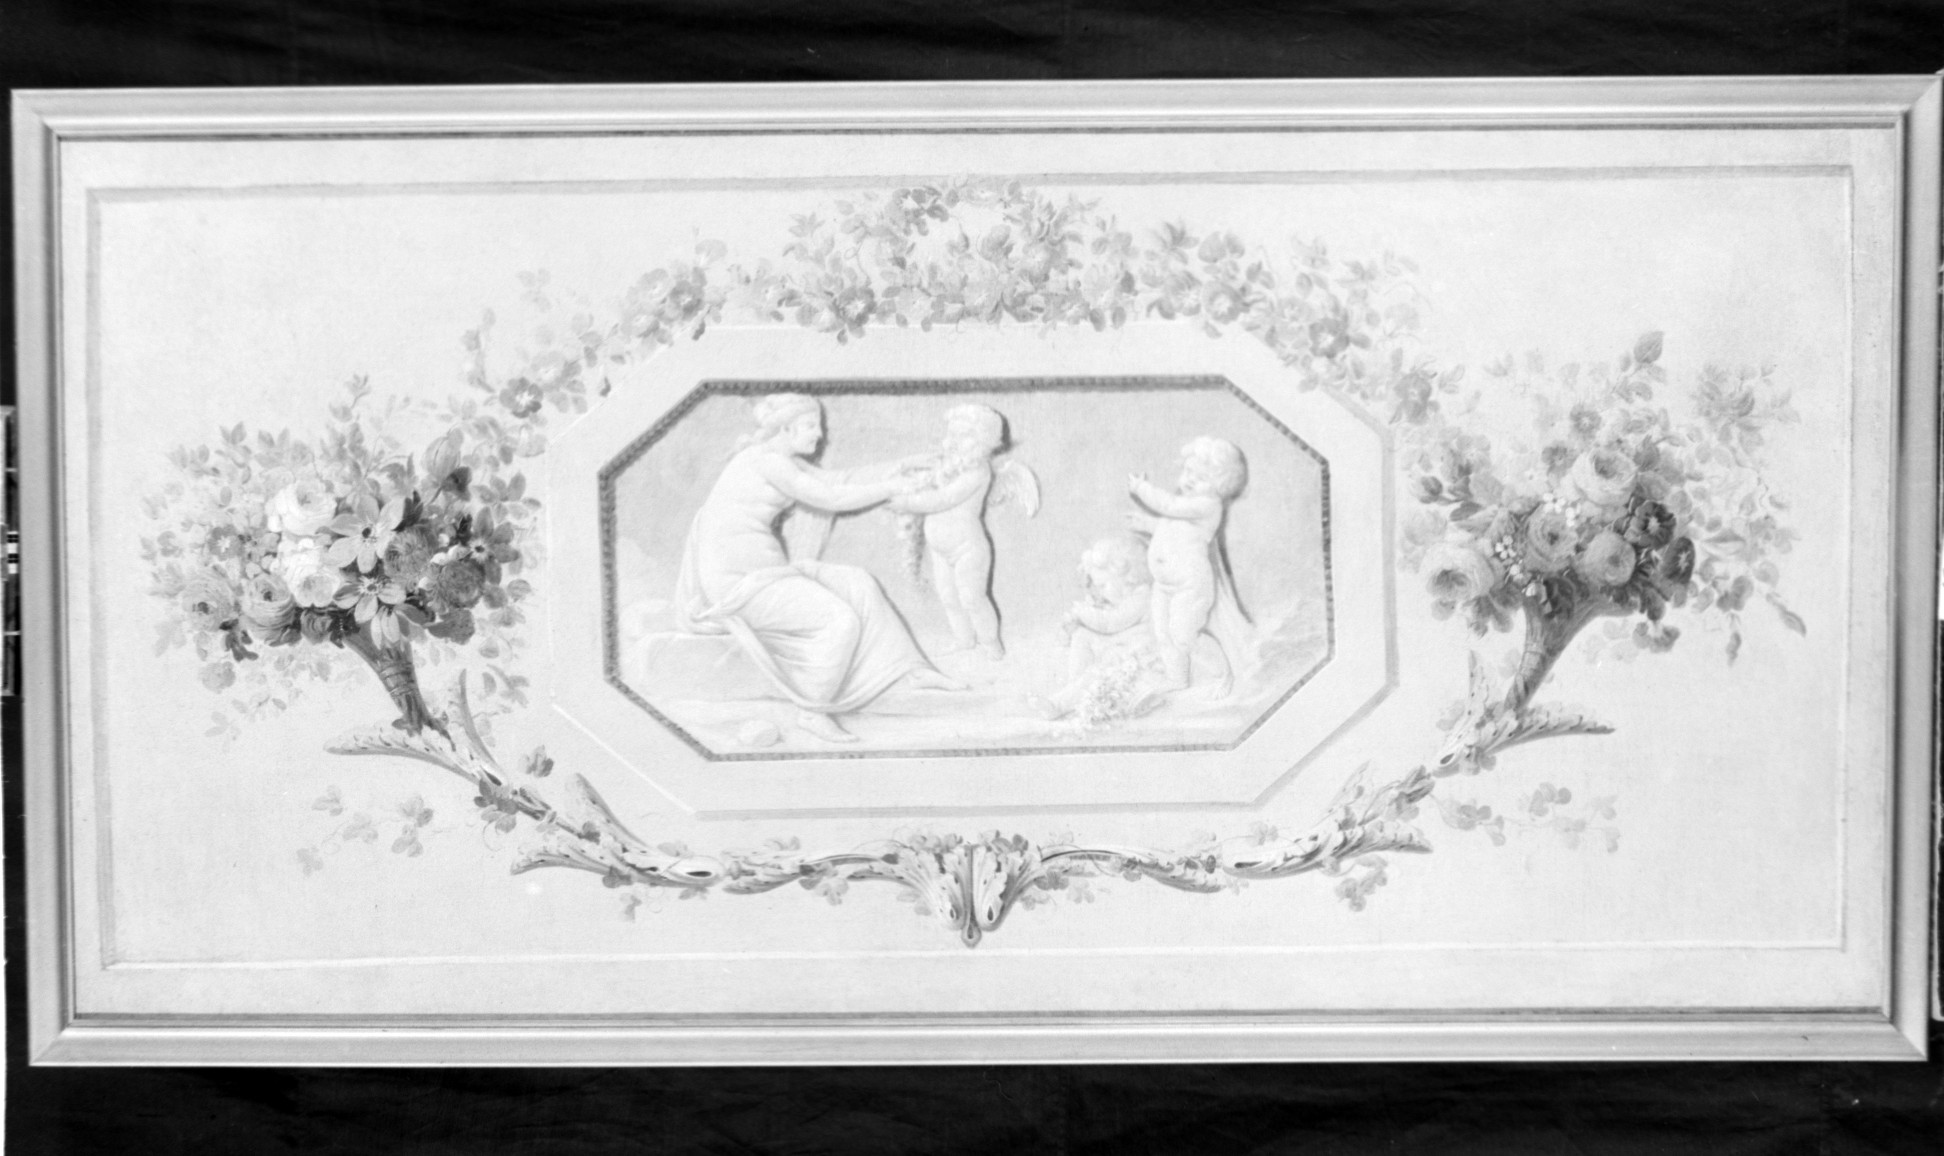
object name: overdoor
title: Nymphs and cupids in an octagonal medallion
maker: french painter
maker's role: artist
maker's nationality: french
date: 1770-1790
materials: canvas, oil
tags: cupid,nymphs,flowers